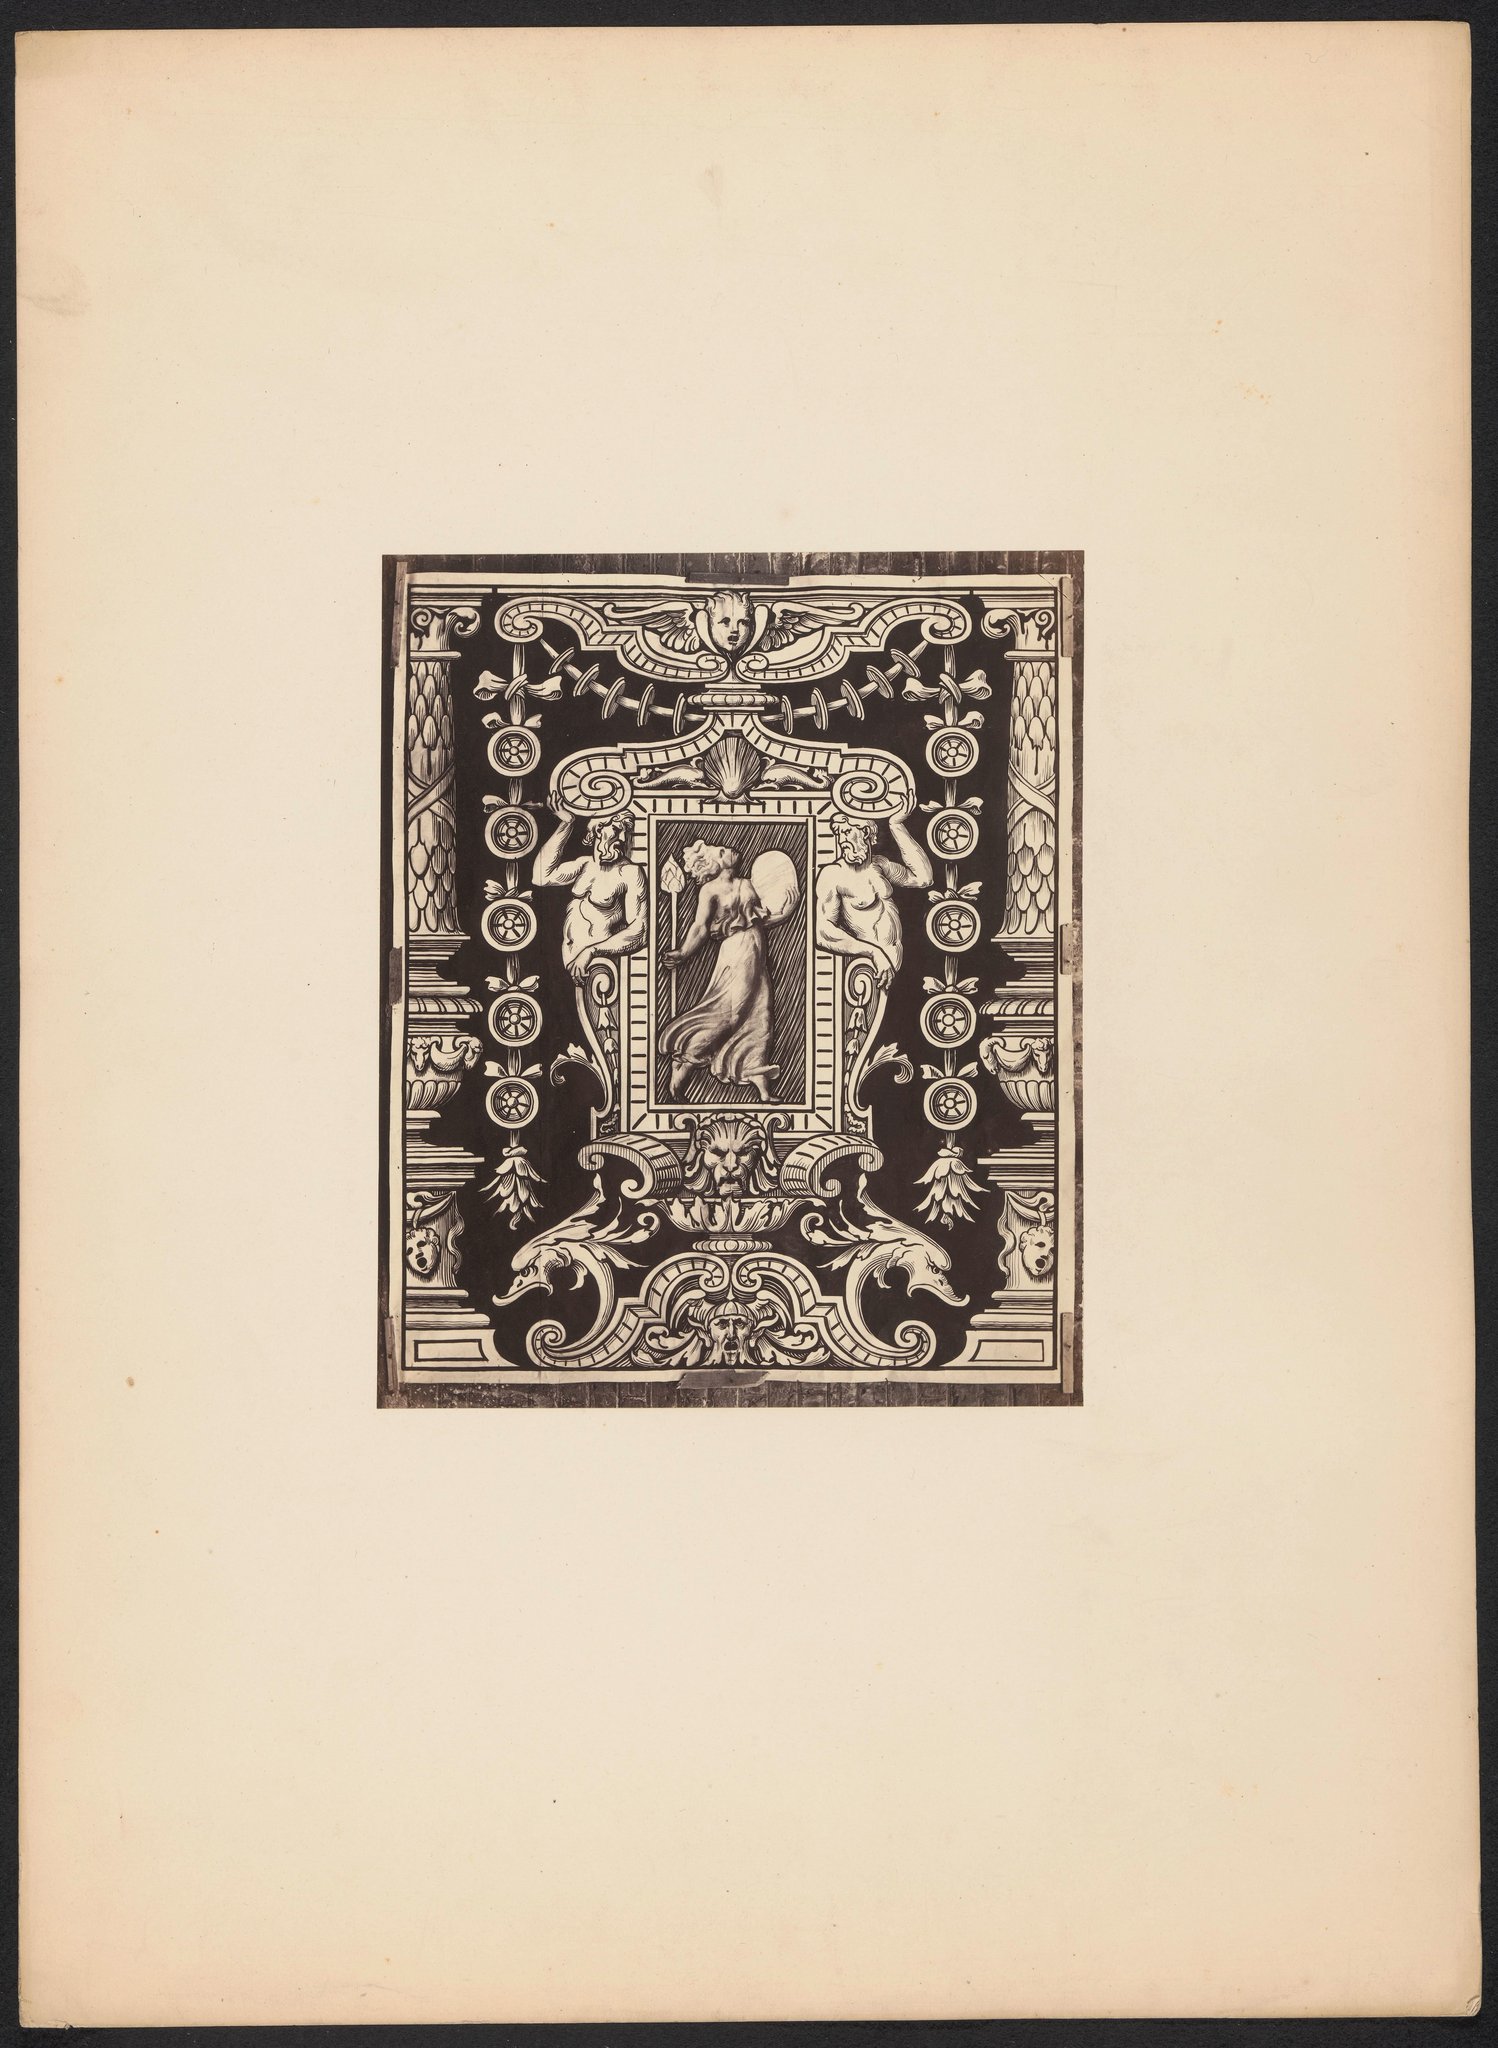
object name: photograph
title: Ornamentprent met fantasiewezens en een staande vrouwenfiguur op een muur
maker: Anonymous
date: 1875-1900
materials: cardboard, photographic support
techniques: albumen print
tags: lion's head ~ ornament, ornament ~ hybrid animals, atlantes ~ architecture, other fantasy ornament, scallop, shell ~ ornament, mask, mascaron ~ ornament, ornament derived from architectural details, walking - aa - female human figure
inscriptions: collector's mark: Lugt 3937